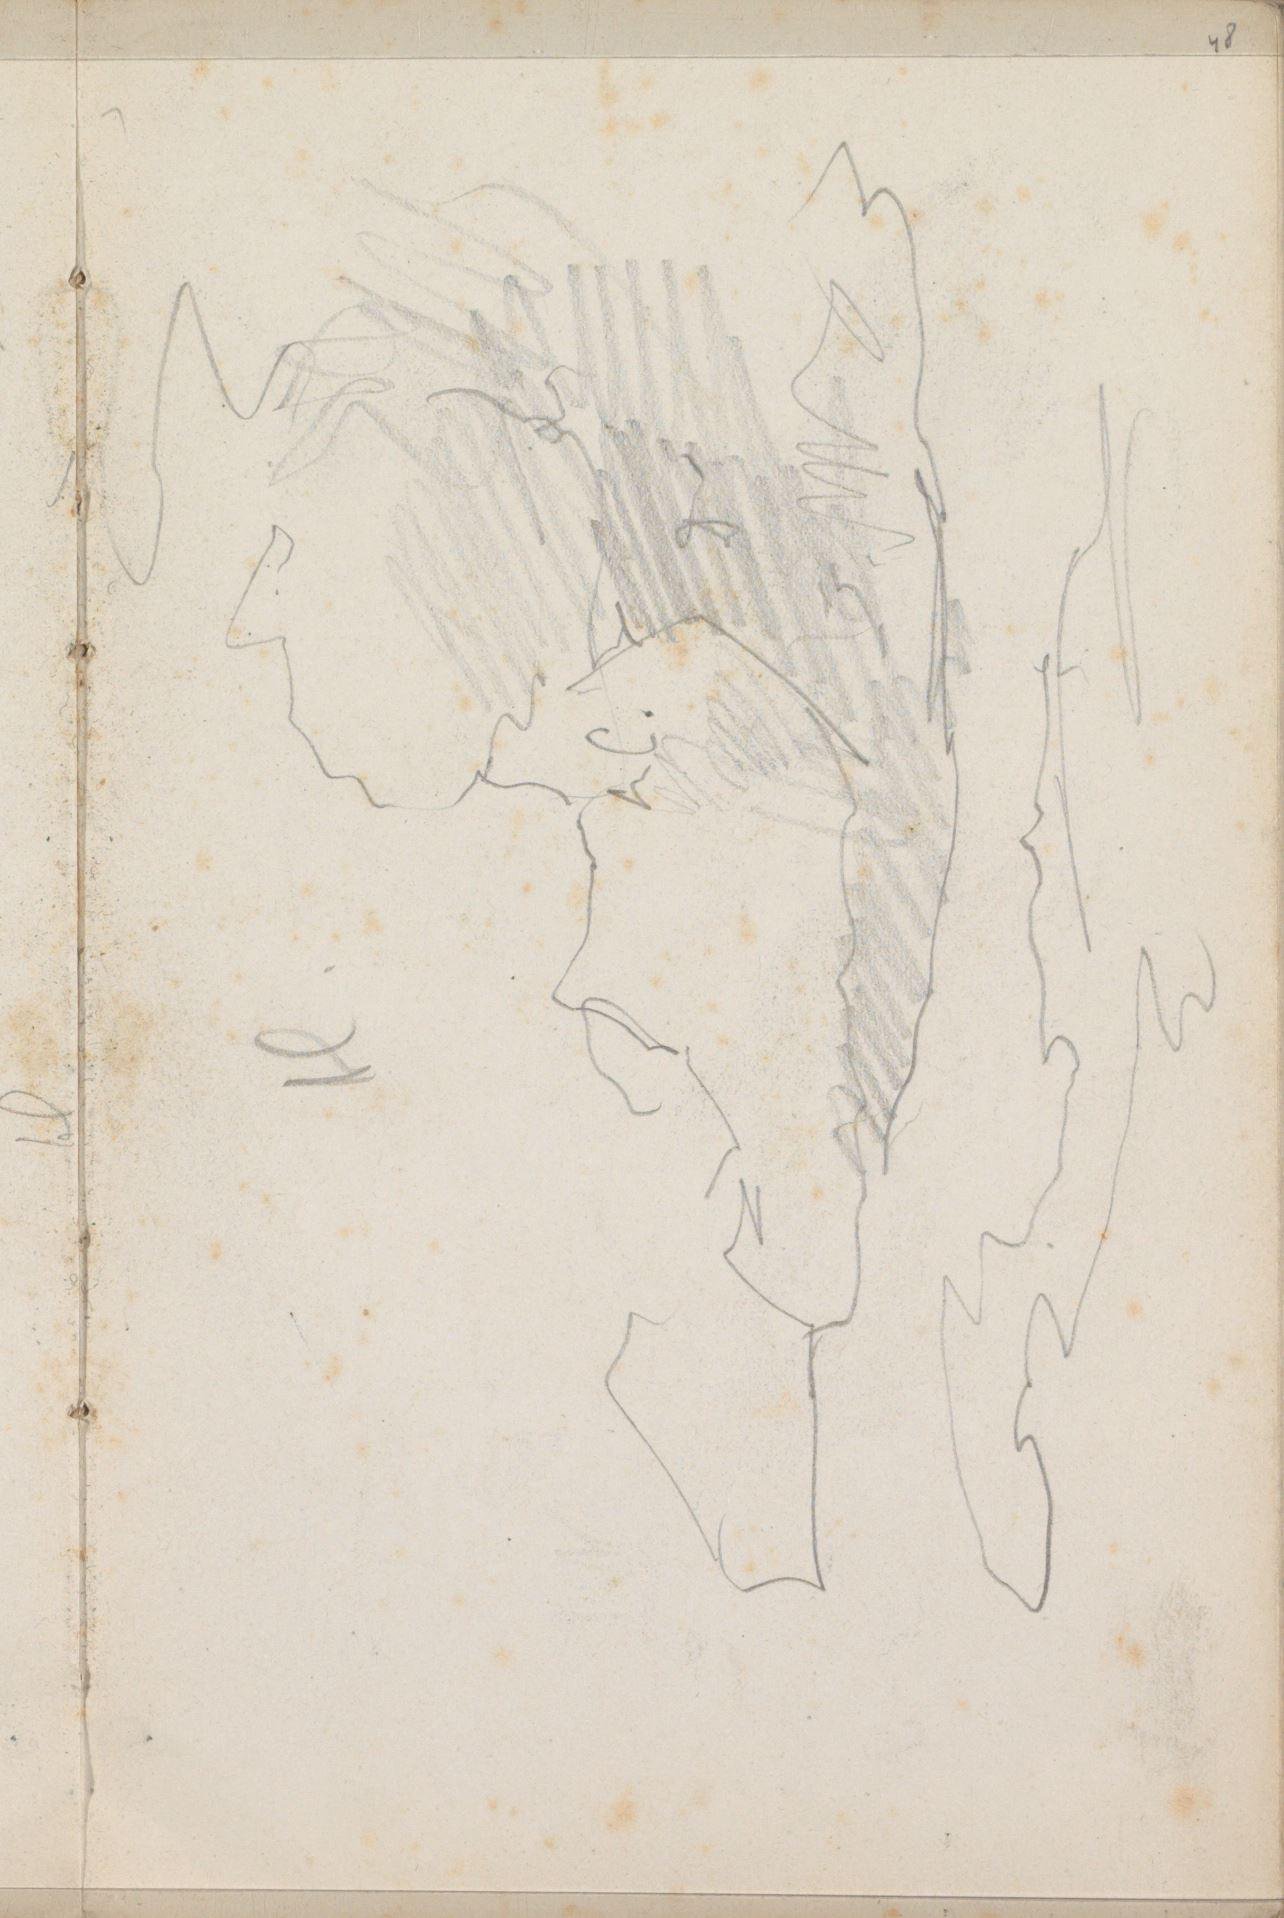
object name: sketchbook leaf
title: Wolkenlucht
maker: george hendrik breitner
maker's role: draughtsman, painter, print maker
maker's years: 1857-1923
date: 1880-1882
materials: paper, pencil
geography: south holland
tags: clouds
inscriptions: kleurnotitie, handgeschreven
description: Pagina 48 uit een schetsboek met 72 bladen.